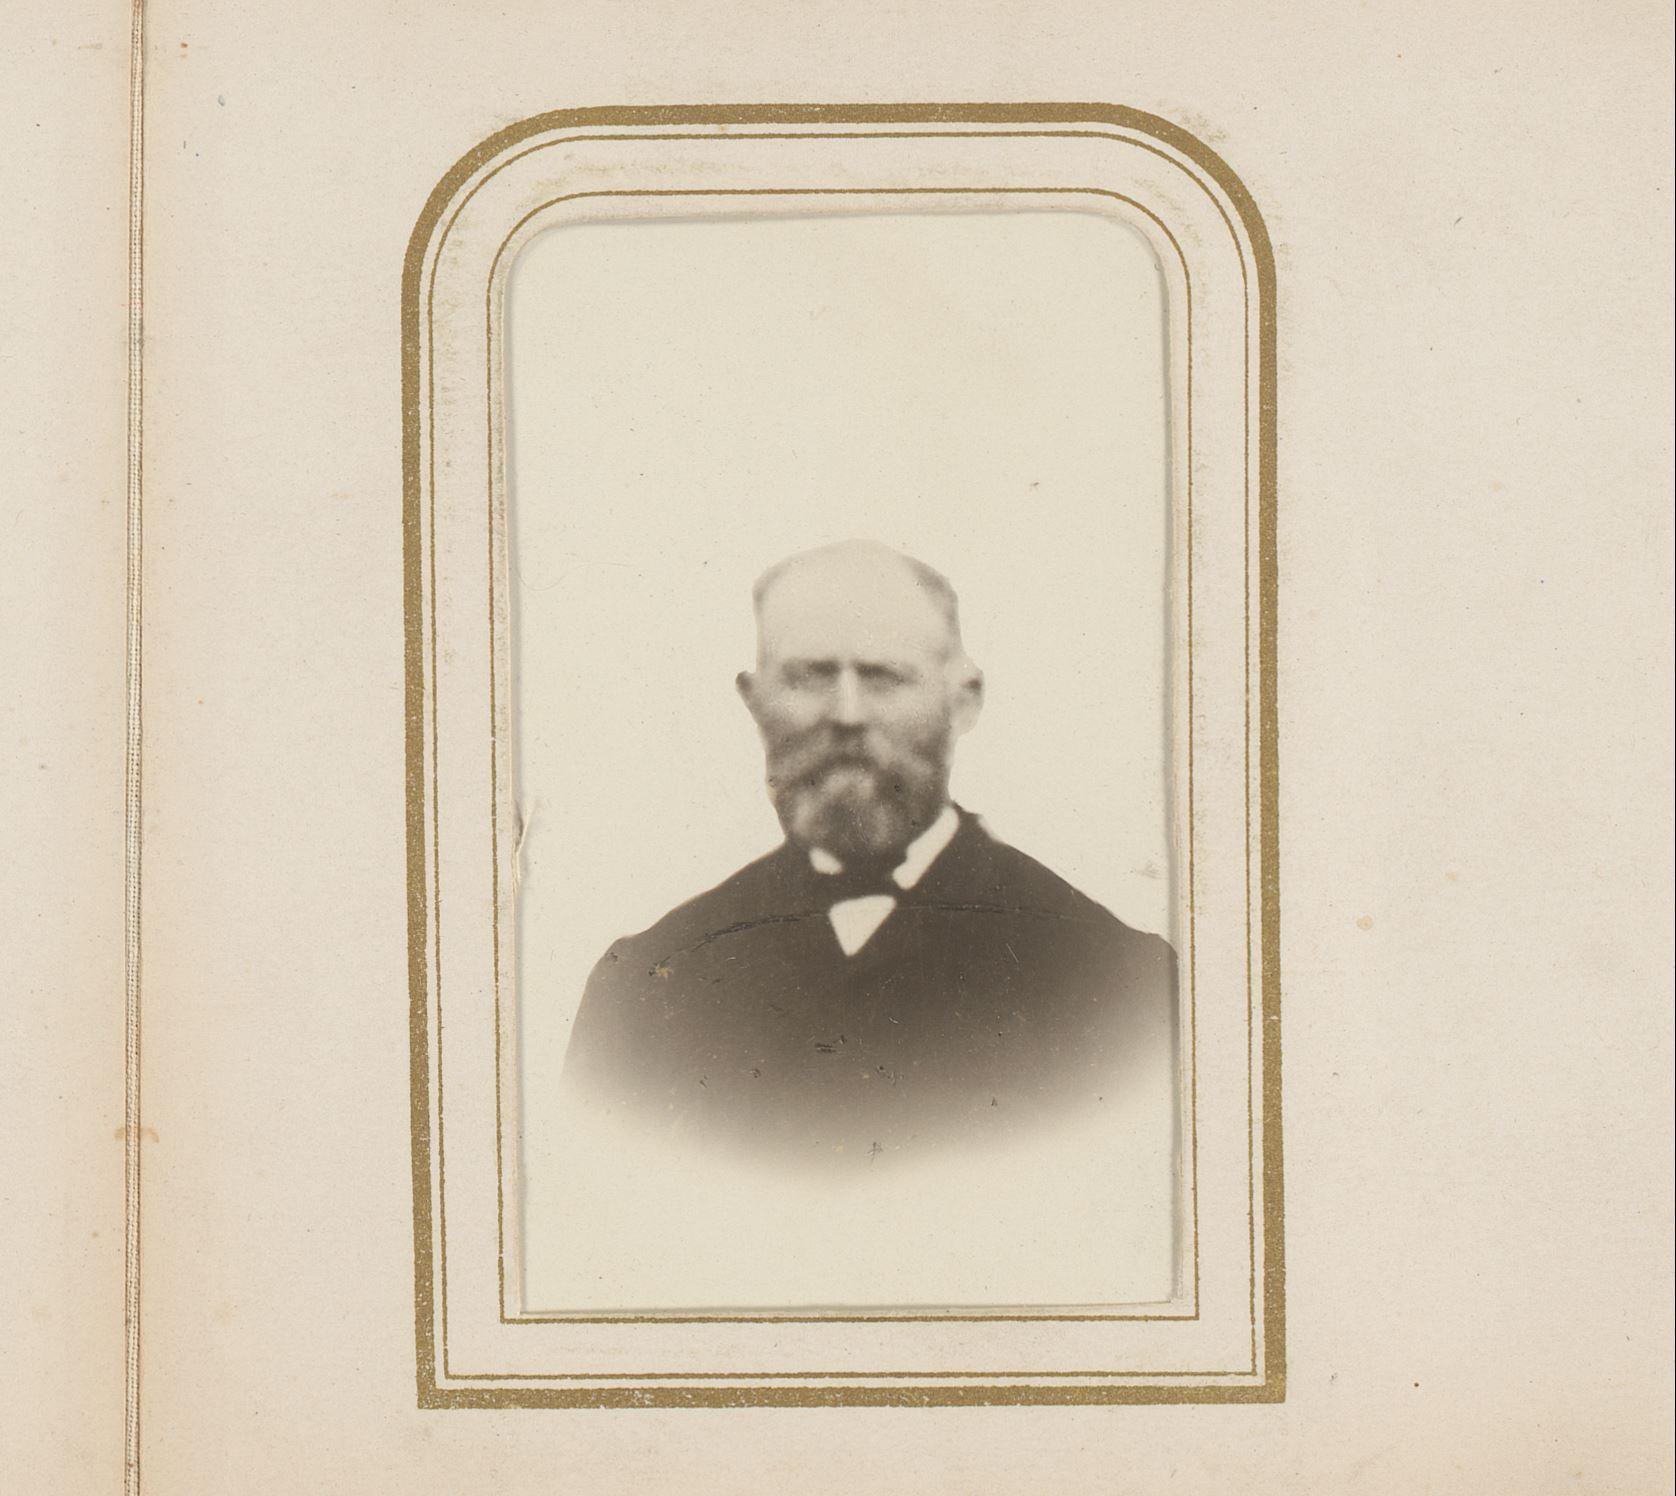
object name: photograph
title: Portret van een man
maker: stanislas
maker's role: fotograaf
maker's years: 1859-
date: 1880-1920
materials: cardboard, photographic support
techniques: gelatin silver print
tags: adult man, historical persons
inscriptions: inscription: ‘Phototgraphie Rivoli/ Stanislas/ Paris/ 33 Rue de Rivoli/ (...)’